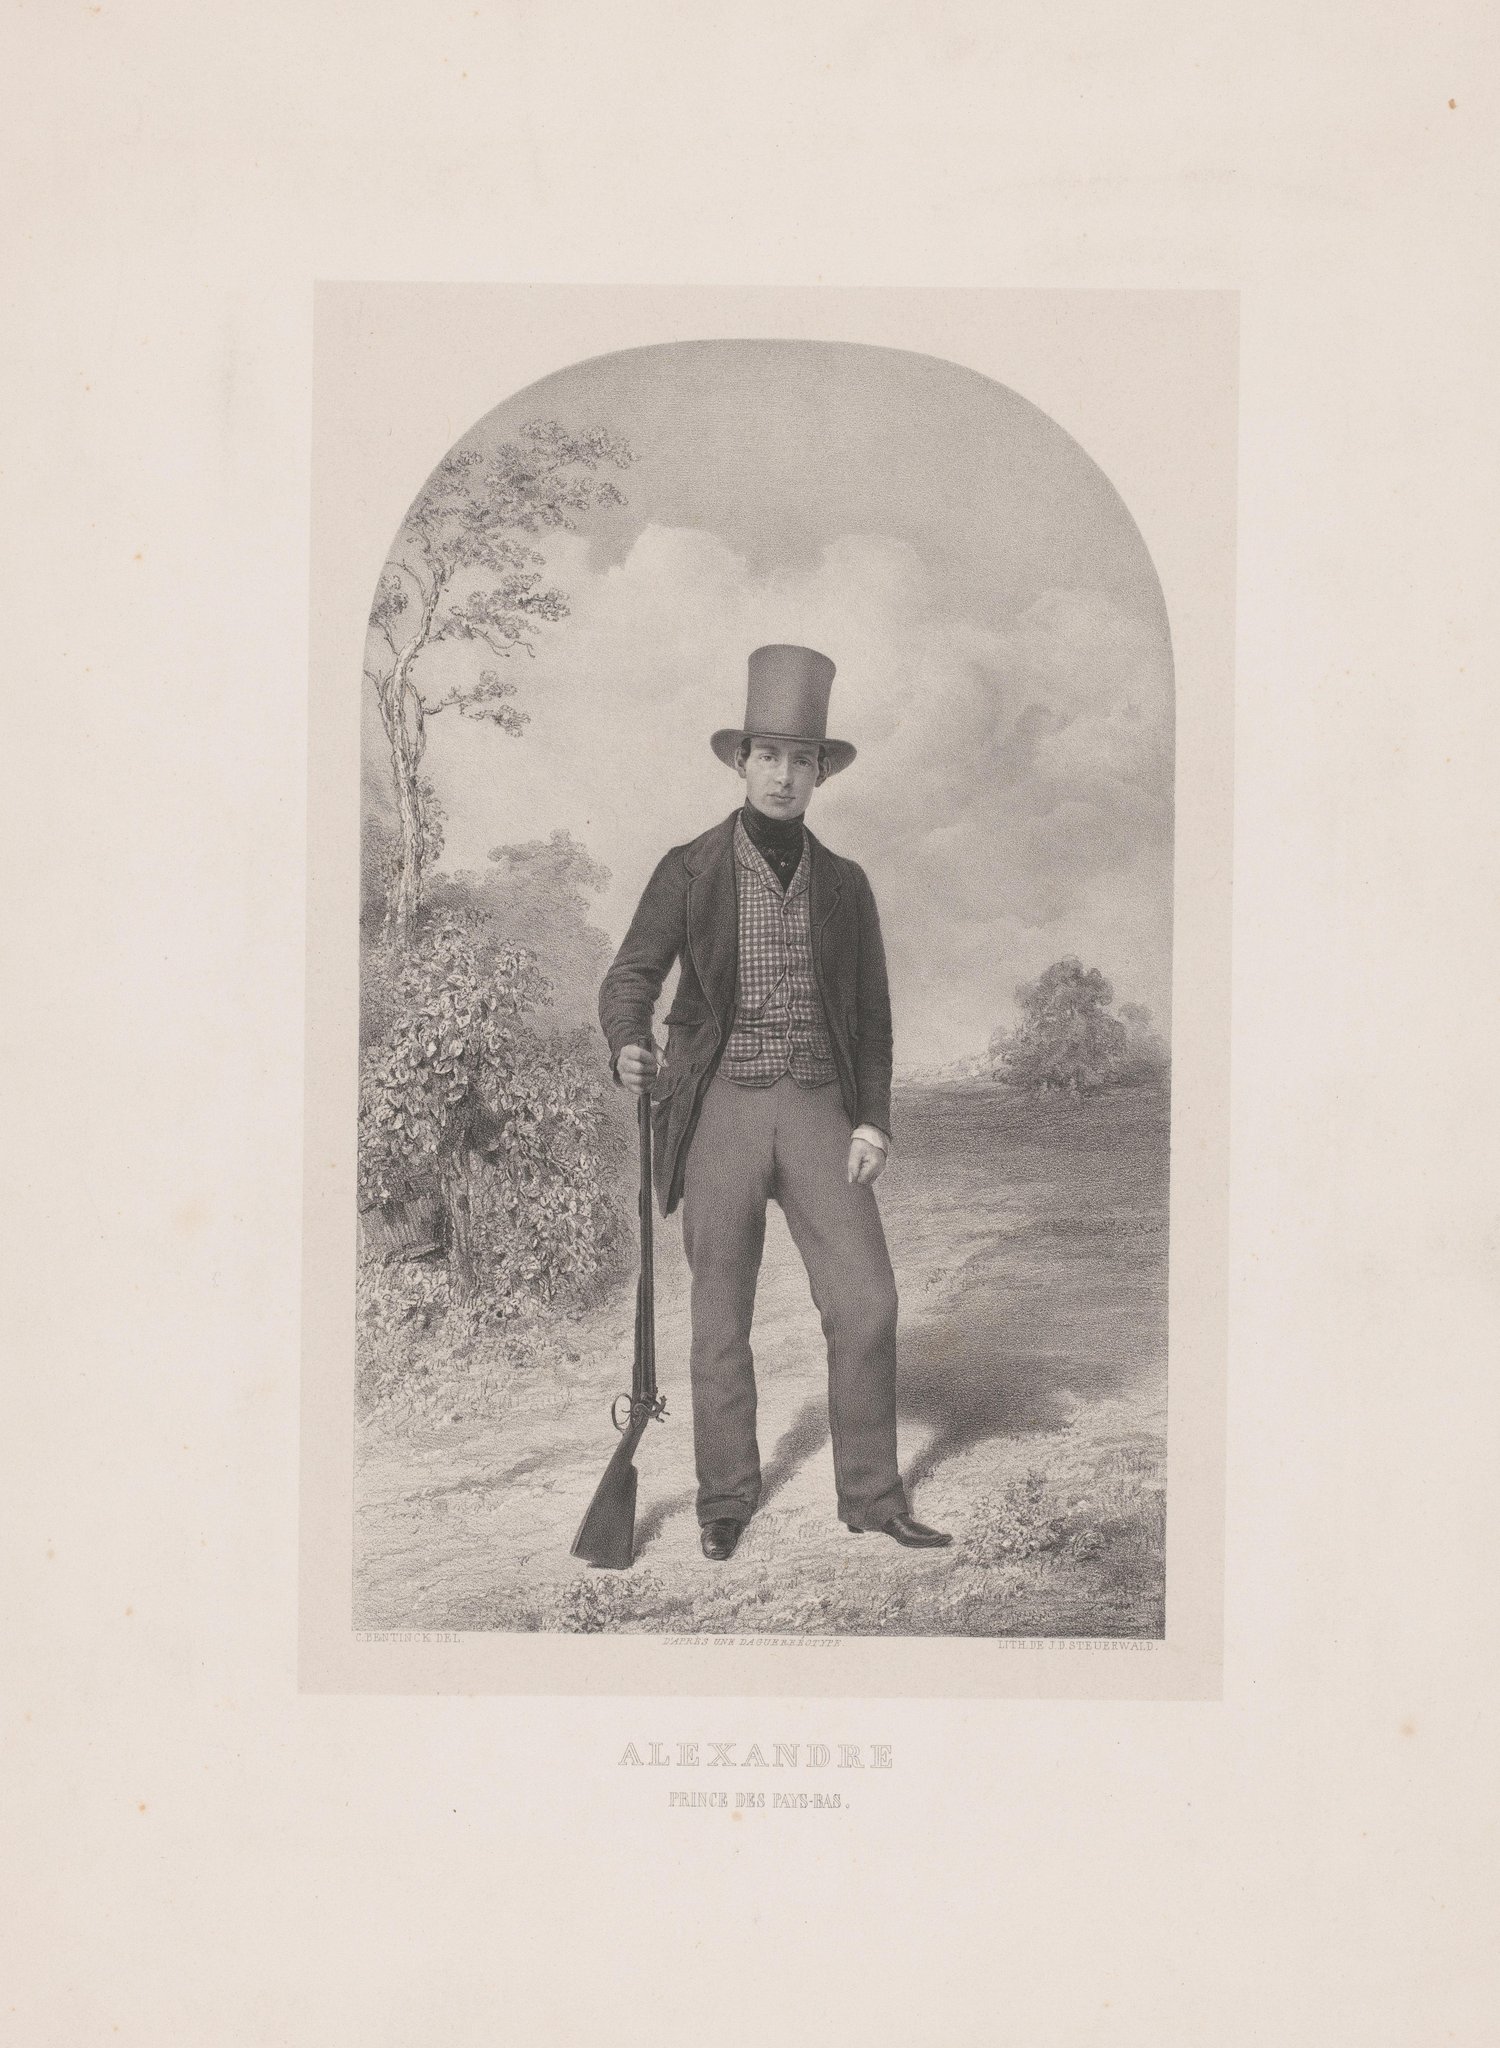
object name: print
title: Alexandre, prince des Pays-Bas repro naar daguerreotypie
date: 1846-1849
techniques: lithograph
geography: the hague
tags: alexander (prins der nederlanden, prins van oranje-nassau), historical persons